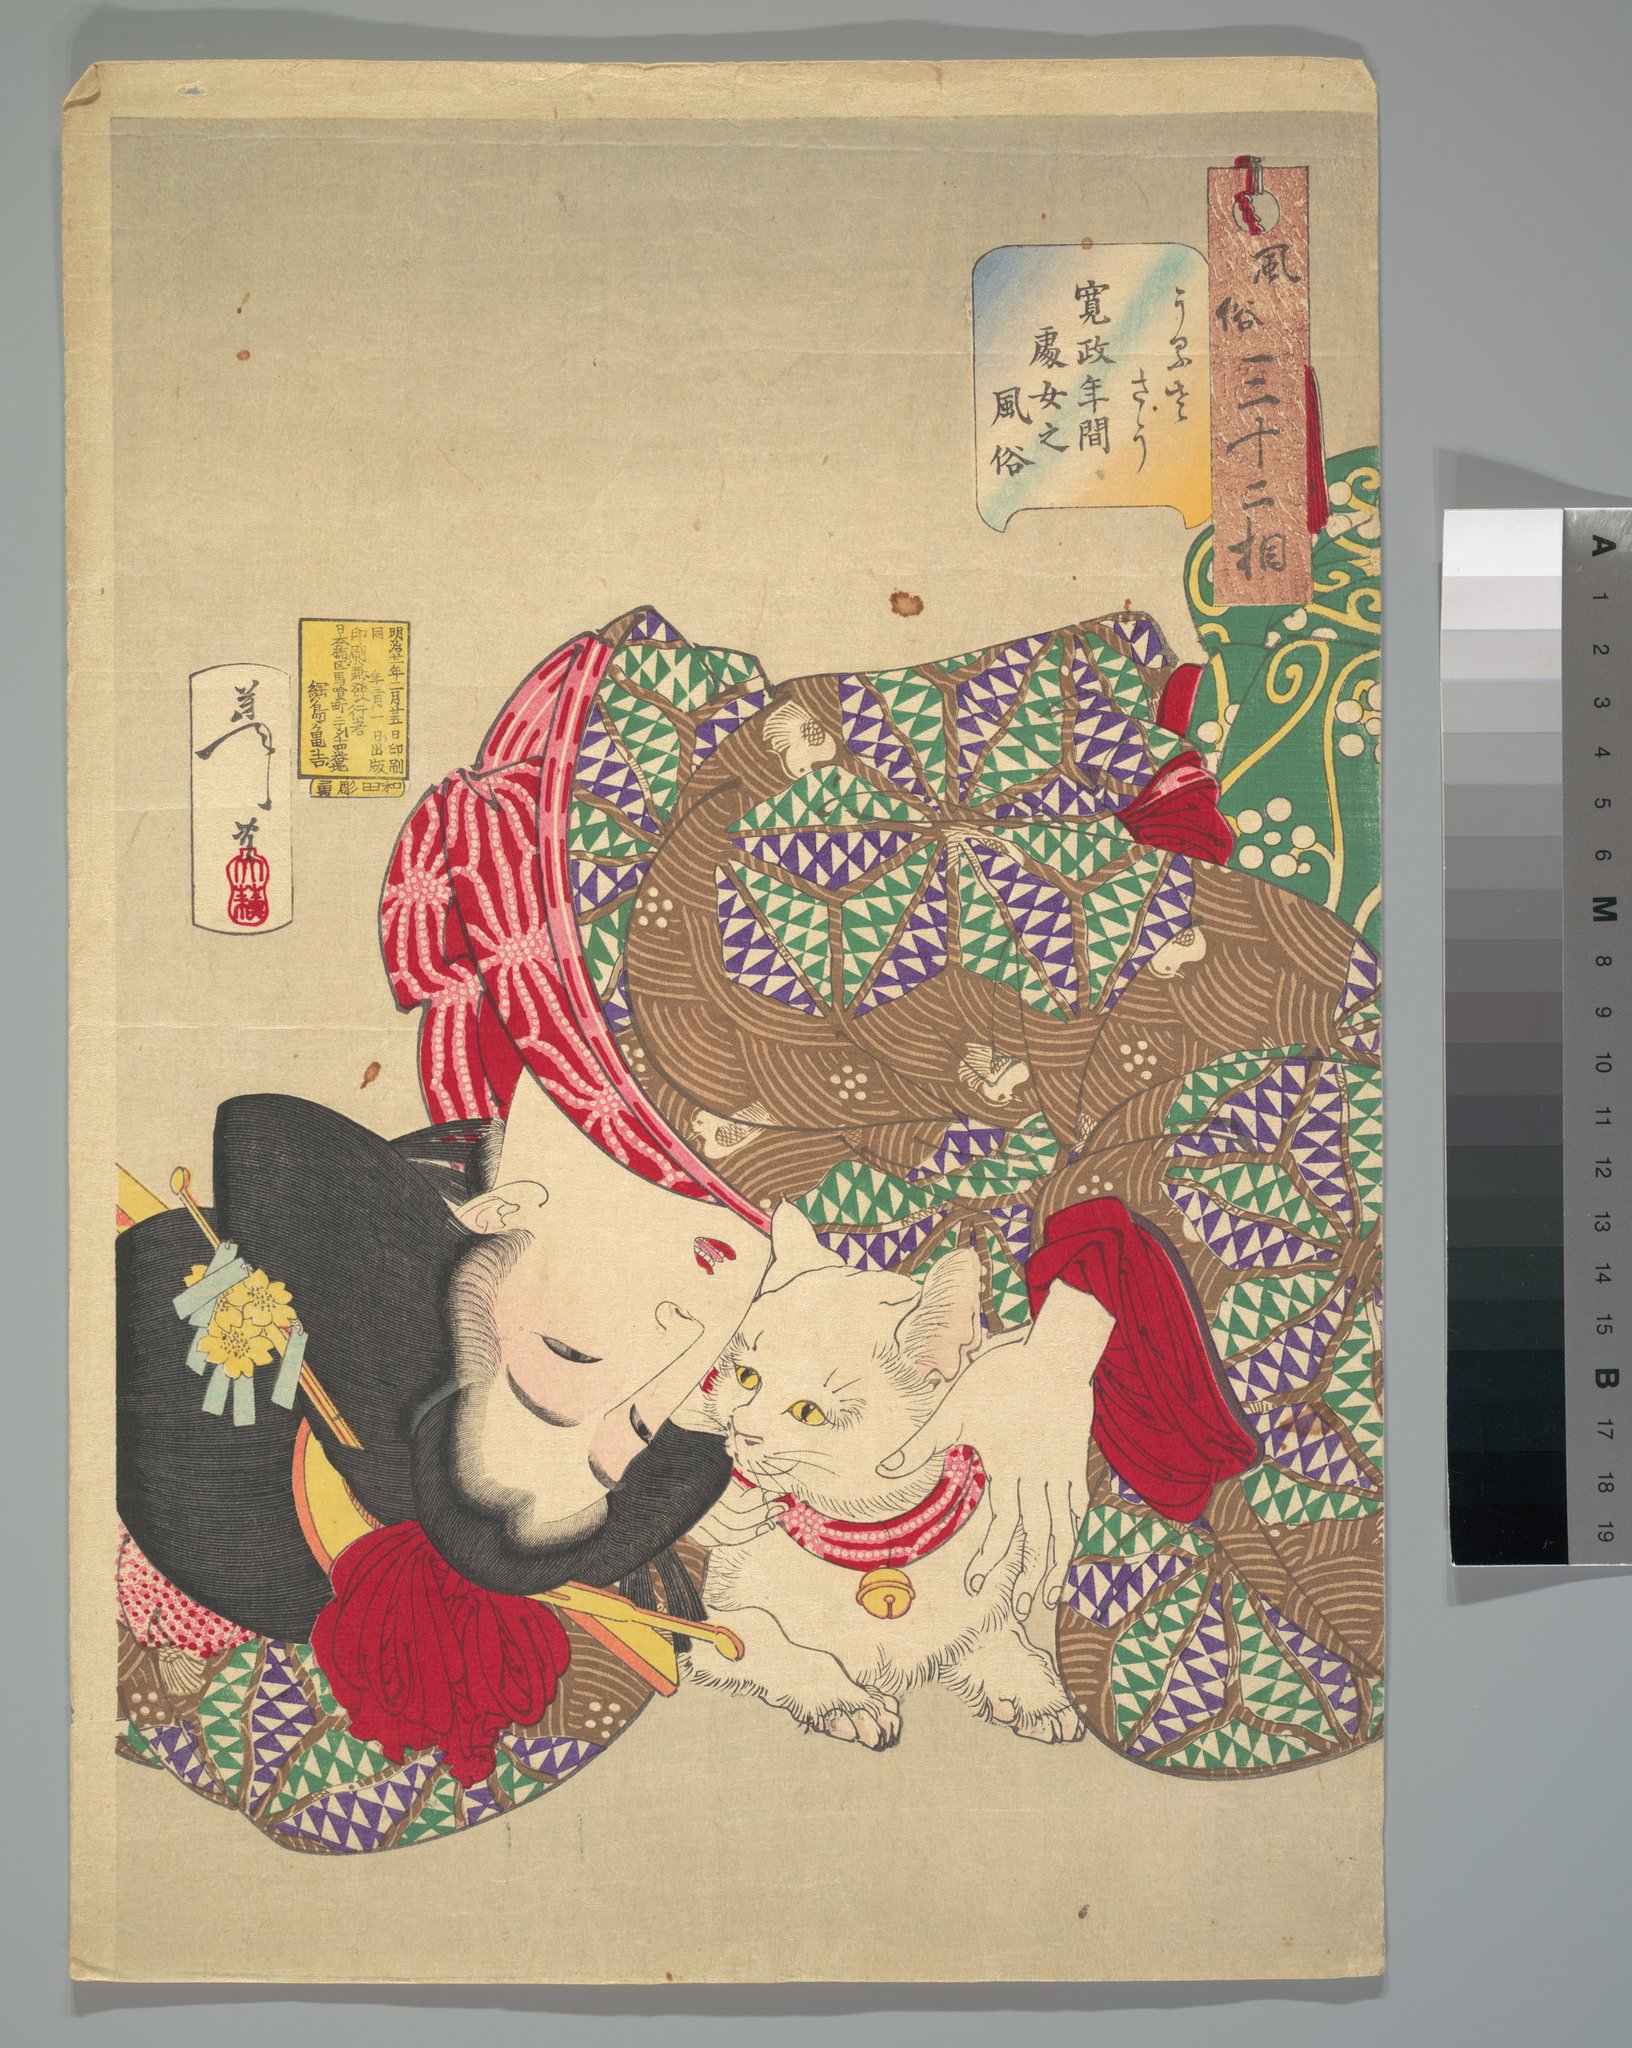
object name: print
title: Teasing the Cat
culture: japanese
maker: tsukioka yoshitoshi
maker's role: artist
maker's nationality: japanese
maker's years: 1839-1892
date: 1888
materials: ink, paper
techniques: woodblock print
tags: women,cats